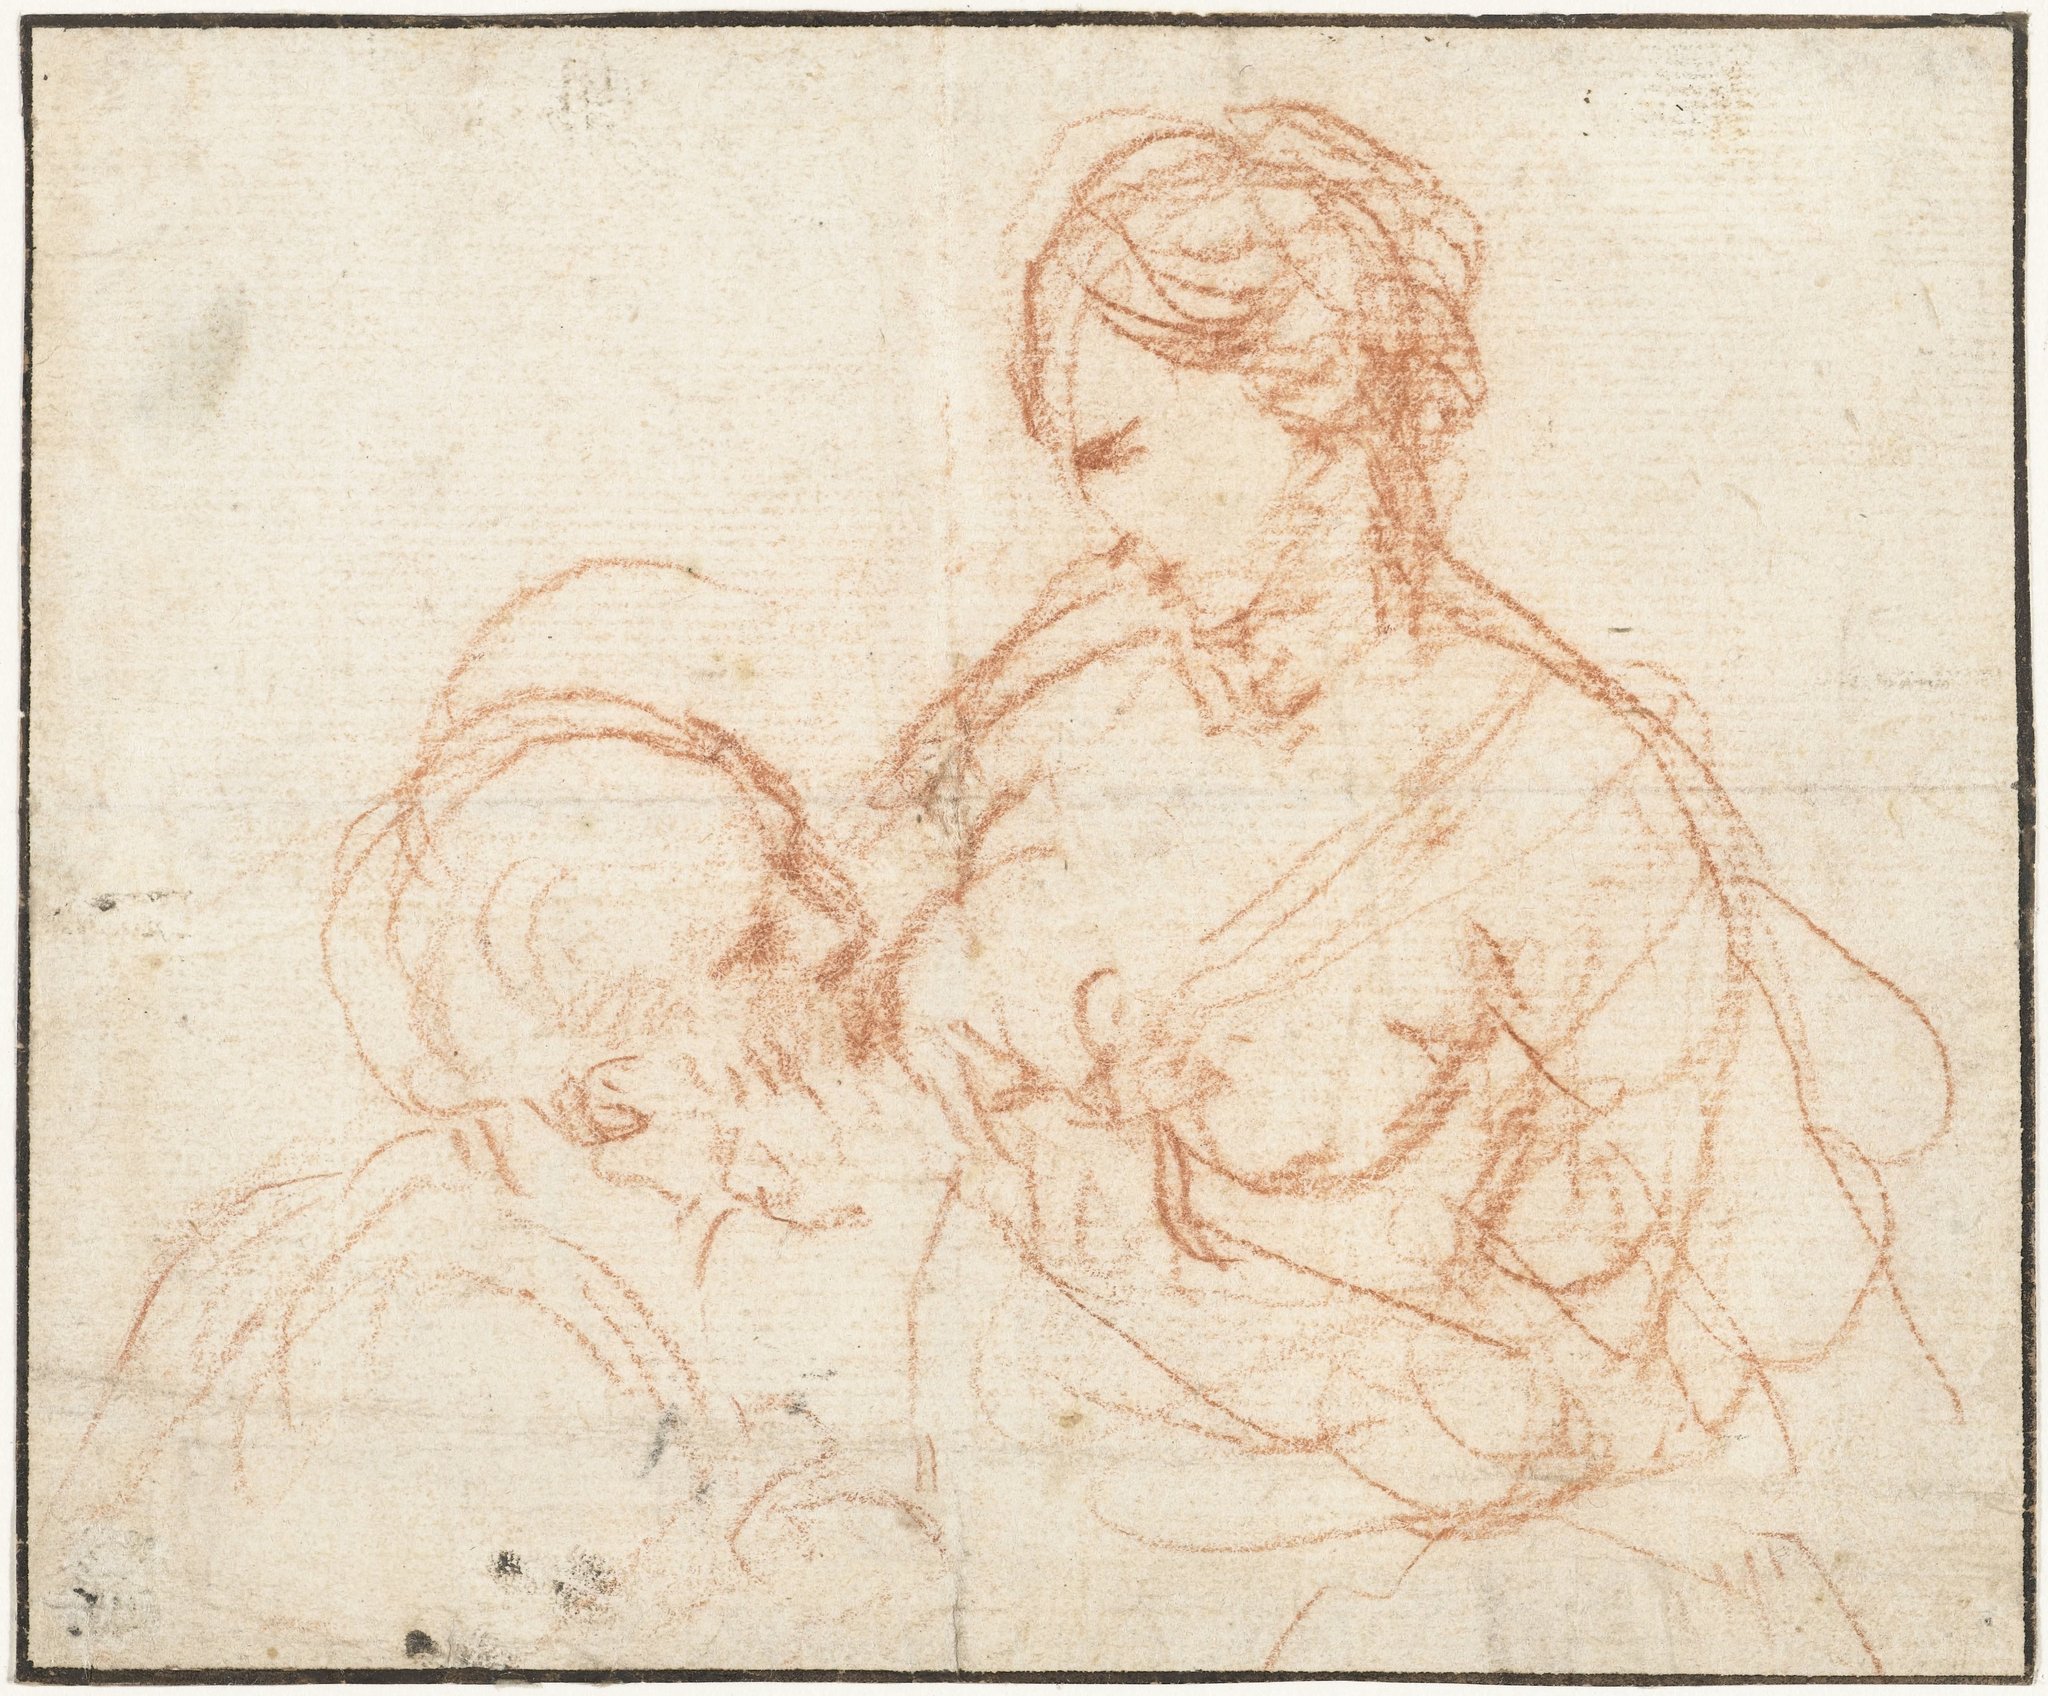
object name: drawing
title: Studie voor Cimon en Pero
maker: guido reni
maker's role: draughtsman, painter, print maker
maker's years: 1575-1642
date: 1616-1620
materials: chalk, paper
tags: pero suckling cimon ('caritas romana')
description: Studie voor Cimon en Pero in een 'Caritas Romana'.